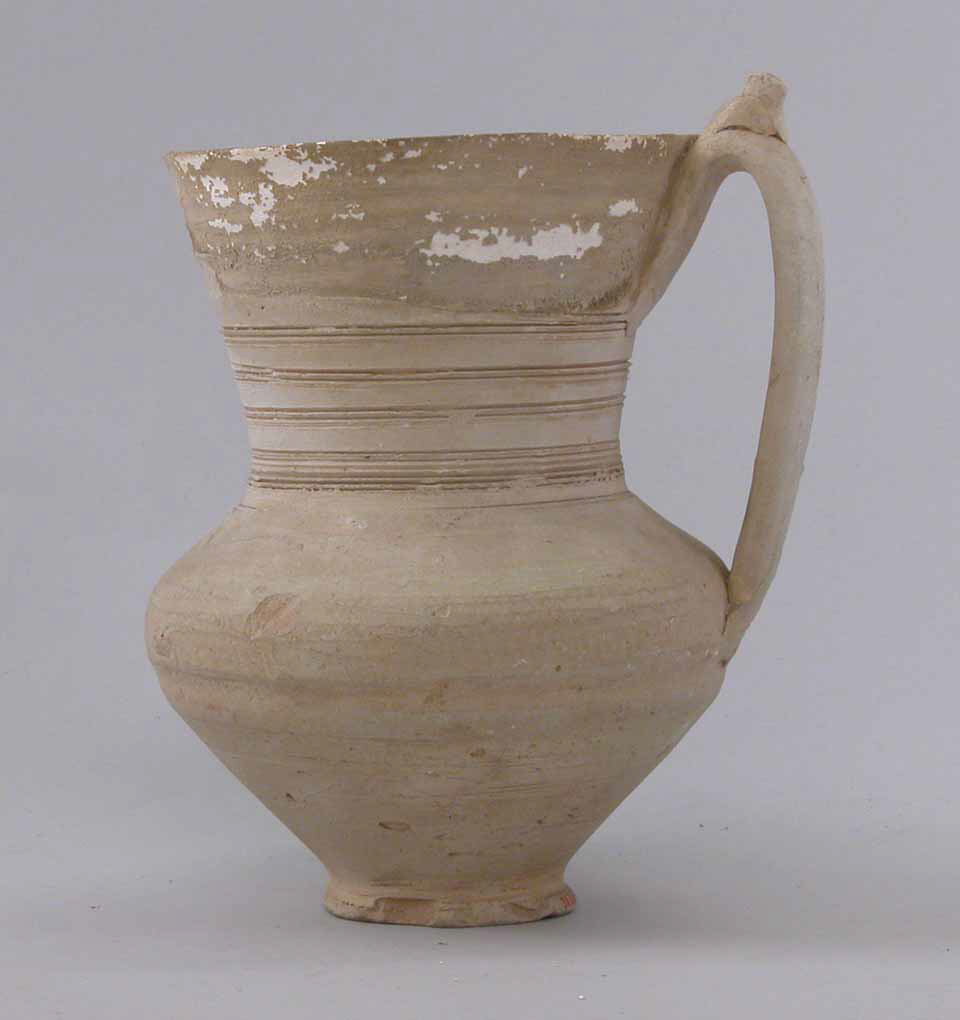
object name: jug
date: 767-833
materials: earthenware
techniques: incising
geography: iran